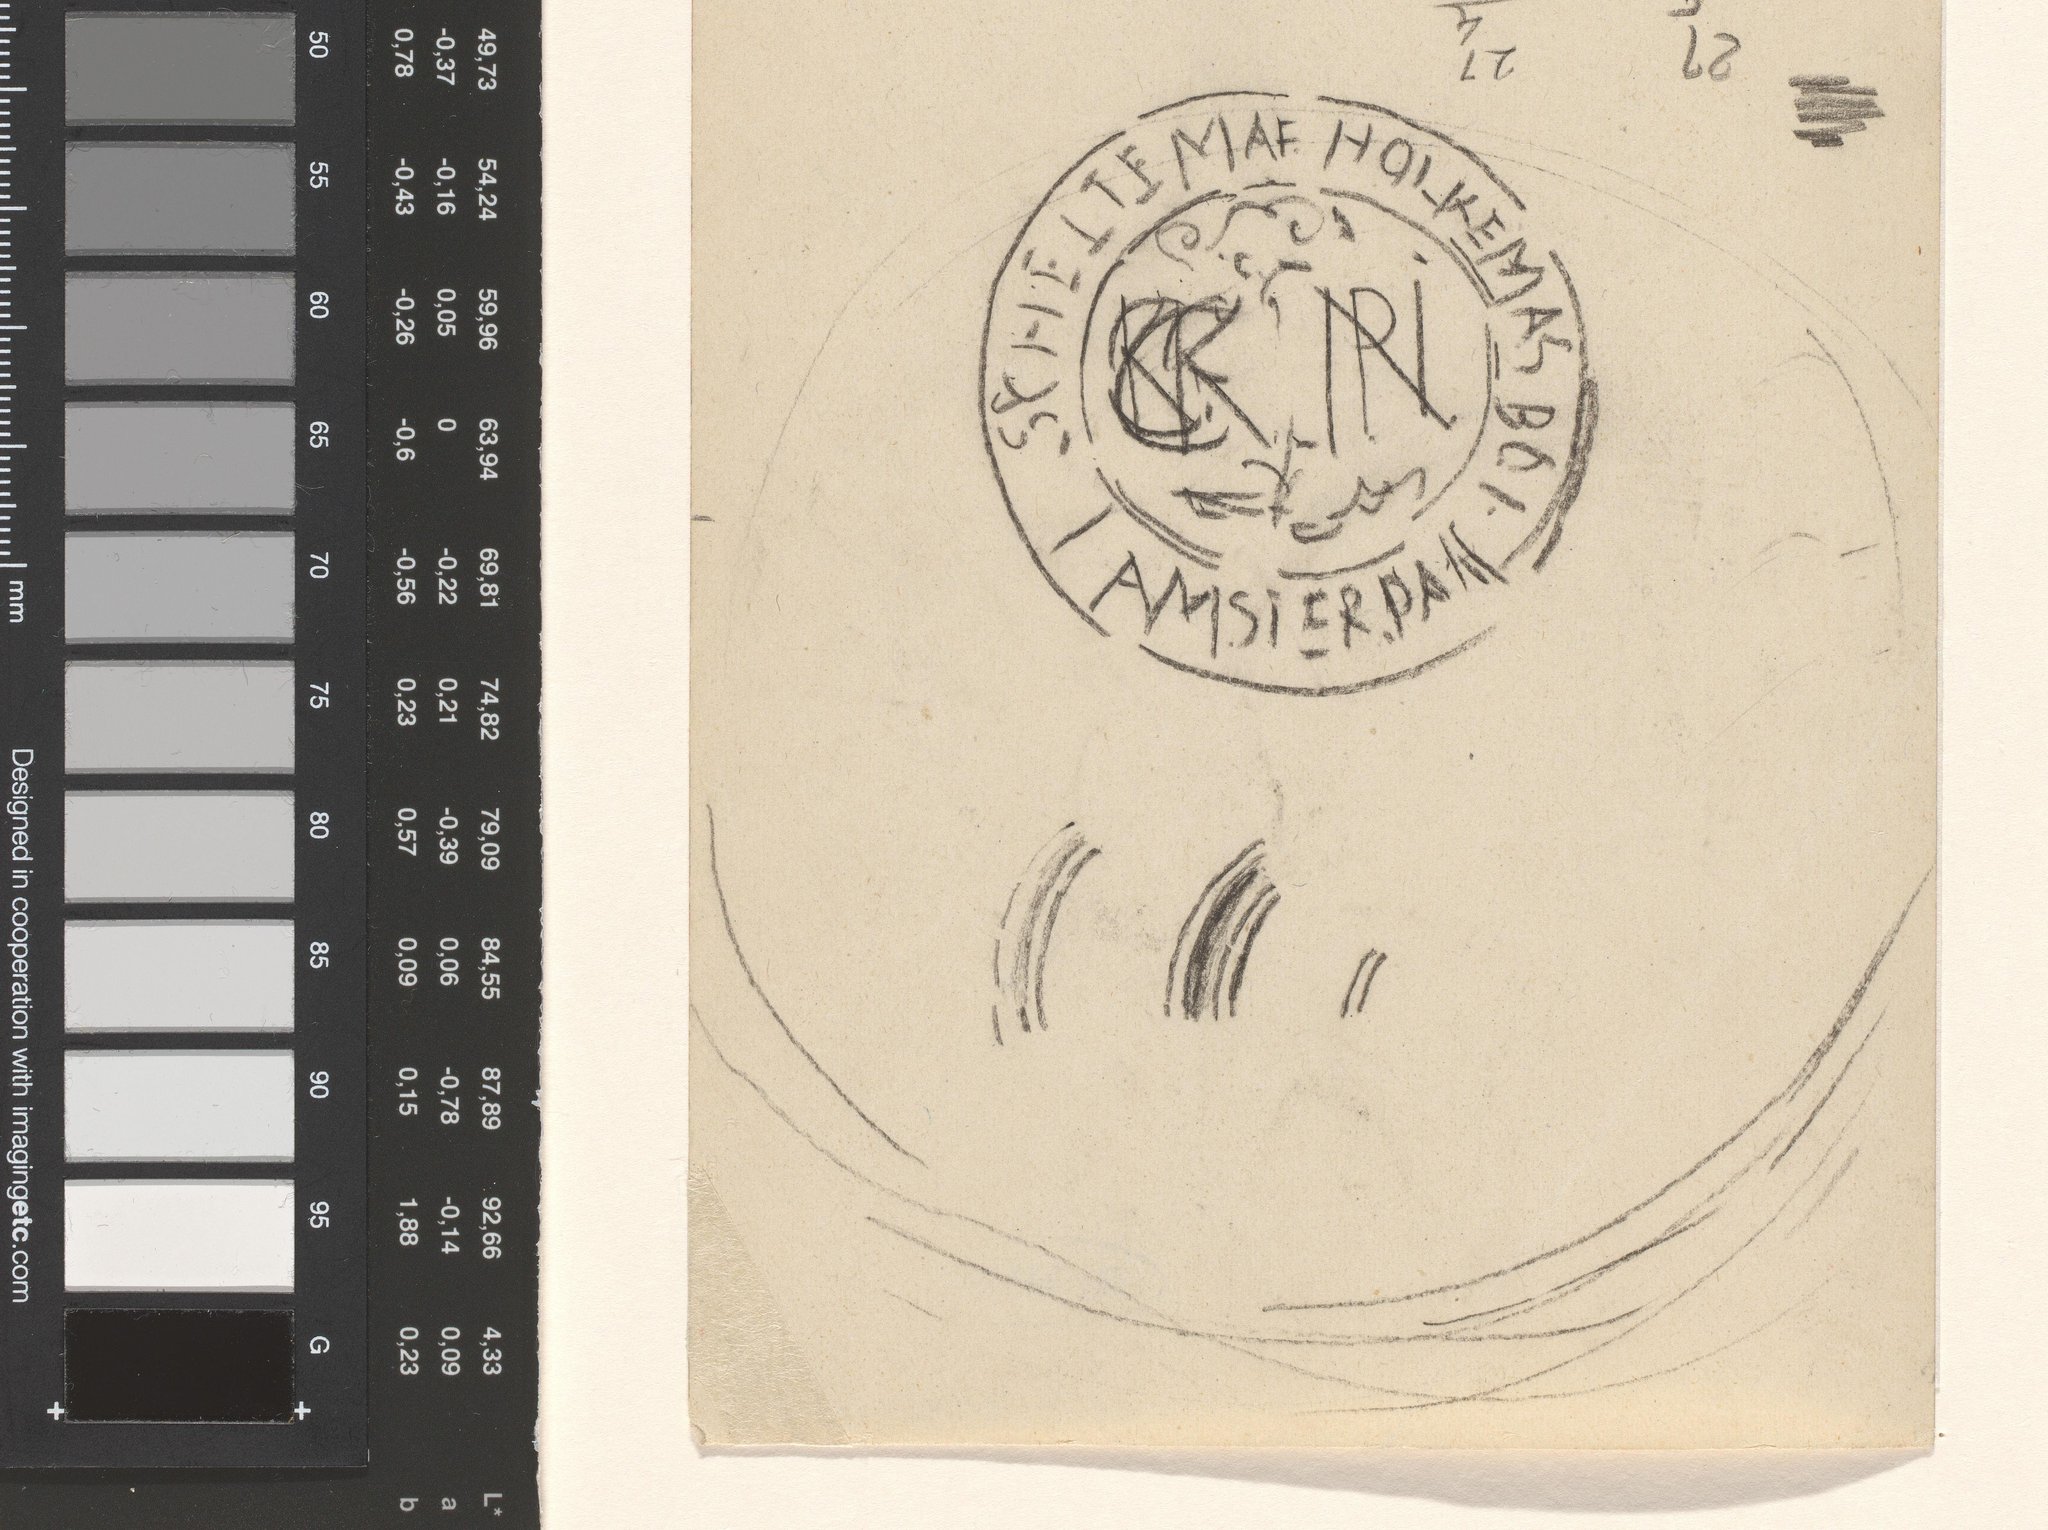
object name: drawing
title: Ontwerp voor een logo van boekhandel Scheltema & Holkema te Amsterdam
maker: gerrit willem dijsselhof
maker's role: designer, draughtsman, print maker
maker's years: 1866-1924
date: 1881-1924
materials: chalk, paper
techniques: drawing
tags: scheltema & holkema's boekhandel